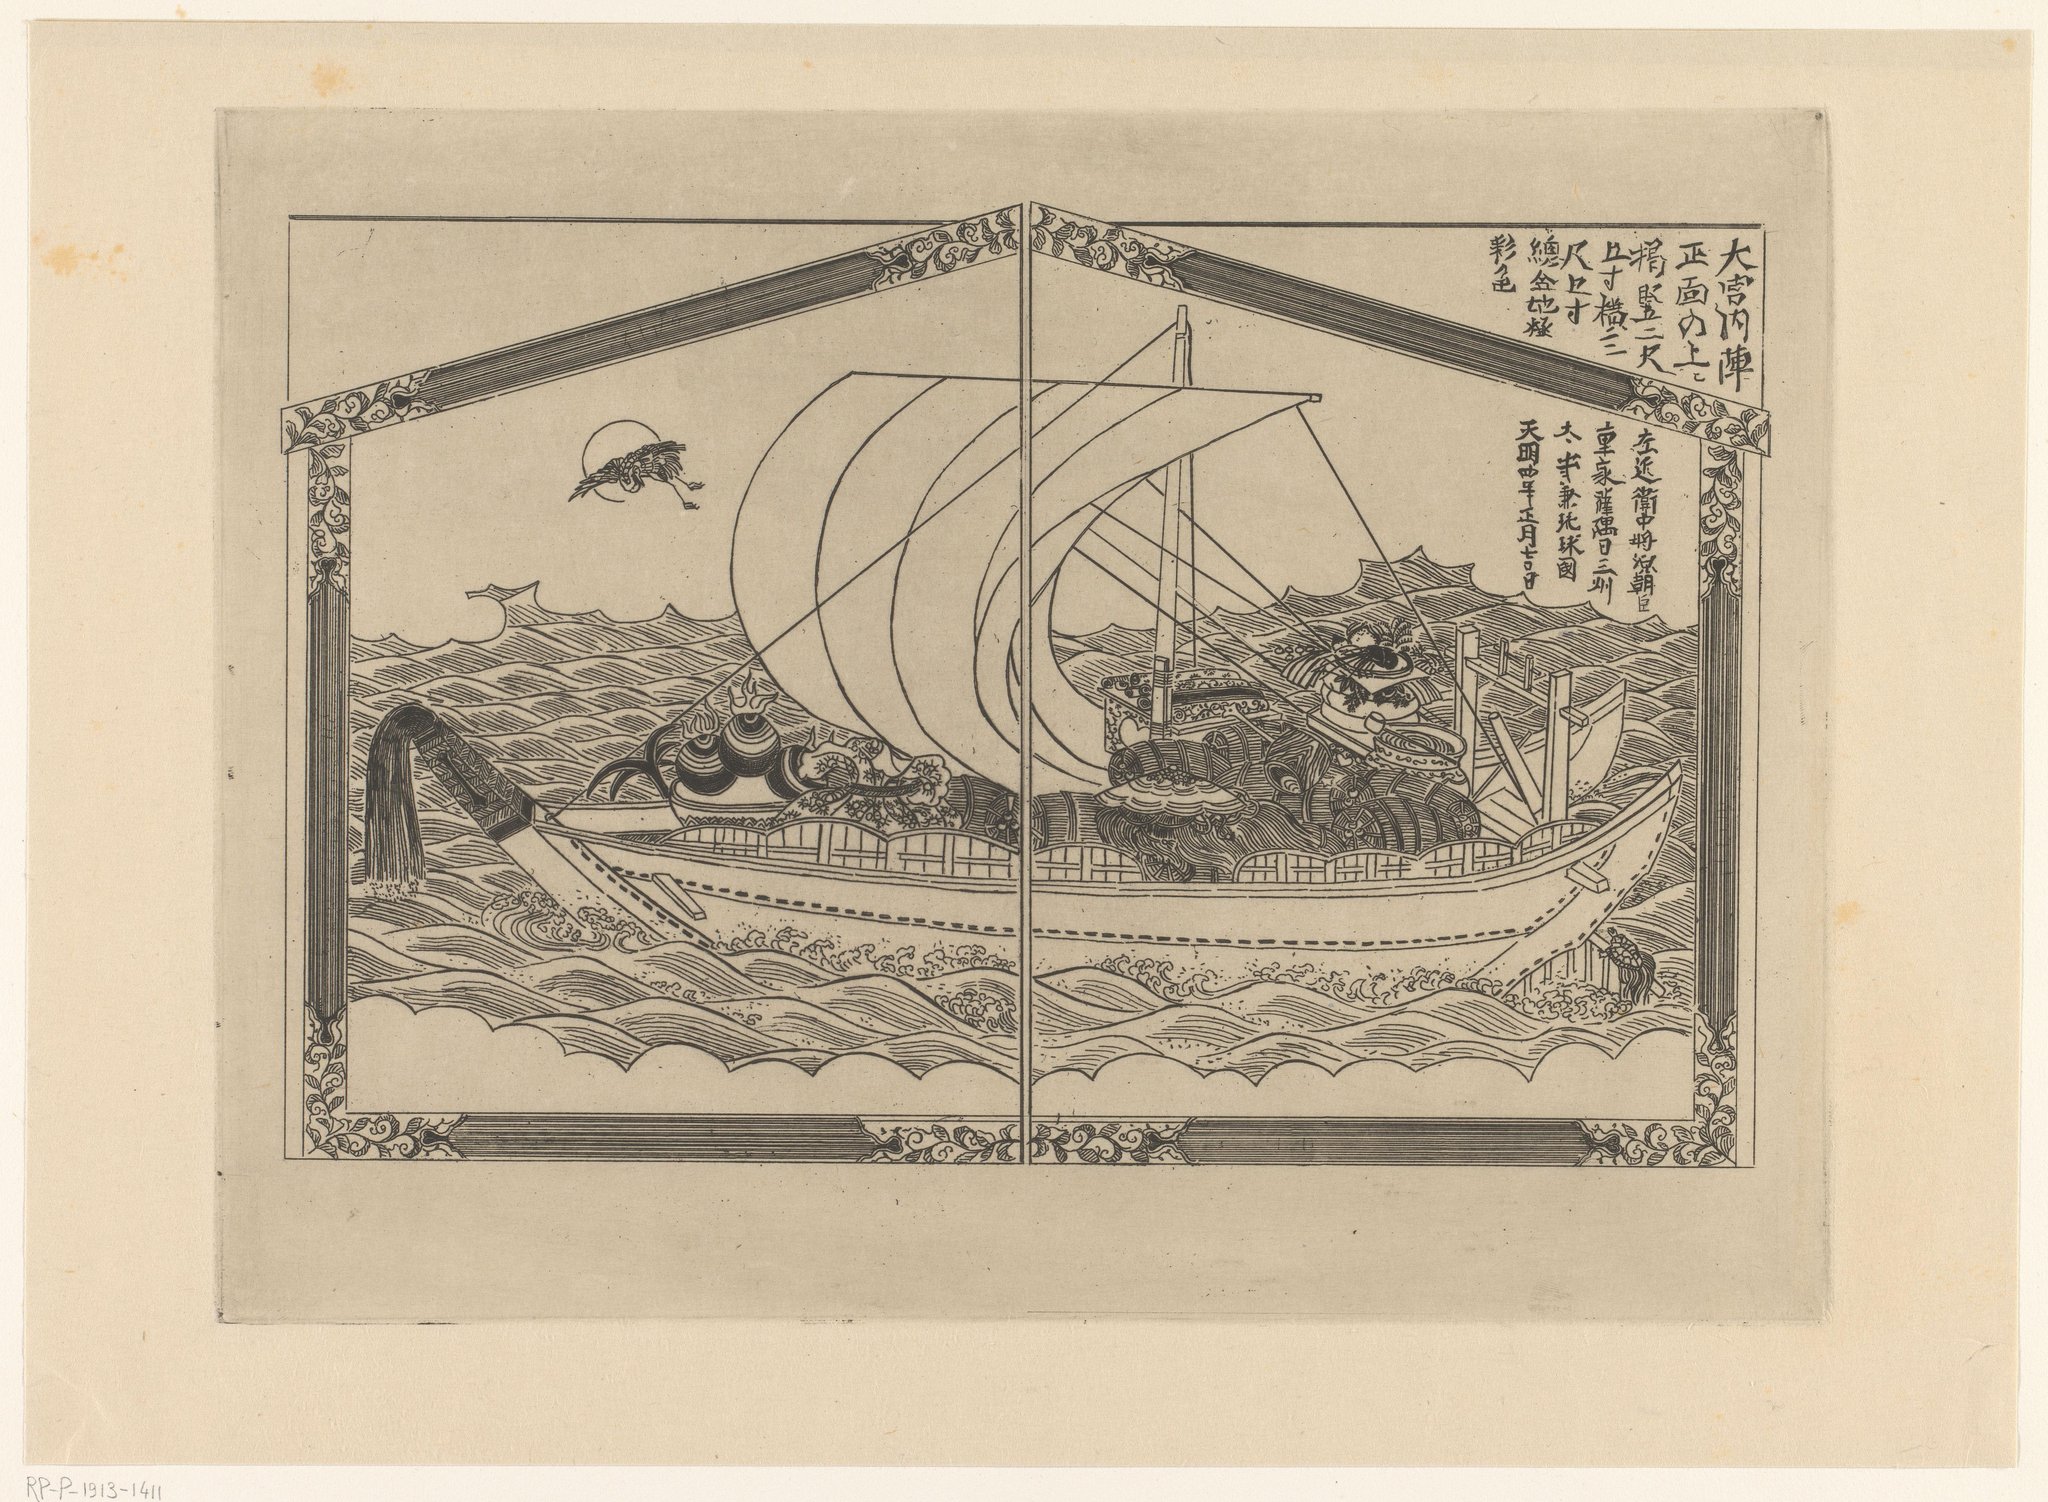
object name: print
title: Boot van Dai-ko-ku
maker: félix hilaire buhot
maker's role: draughtsman, print maker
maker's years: 1847-1898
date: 1883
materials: paper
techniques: etching, intaglio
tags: wooden container: barrel, cask, bucket, sailing-ship, sailing-boat, sea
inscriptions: collector's mark: Lugt 2233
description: Prent uit een serie bestaande uit acht platen plus titelprent en ex libris, naar Japanse objecten uit de collectie van Philippe Burty, uitgegeven in Parijs door Edmond Sagot in (april) 1883. In dat jaar vond er een belangrijke tentoonstelling plaats evenals andere Japan-georiënteerde activiteiten. Op 10 april 1883 opende de eerste retrospectieve tentoonstelling van Japanse kunst in de Westerse wereld in de Gallery Georges Petit op de Rue de Sèze te Parijs. Volgens een brief van Buhot aan Octave Uzanne, gedateerd 4 april 1883, had Buhot in 1875 reeds negen van de tien platen vervaardigd. Bourcard & Goodfriend vermelden dat er van de serie vijftig waren gedrukt op Japans papier, honderd op Nederlands papier en enkelen op geel met goud bewerkt papier.